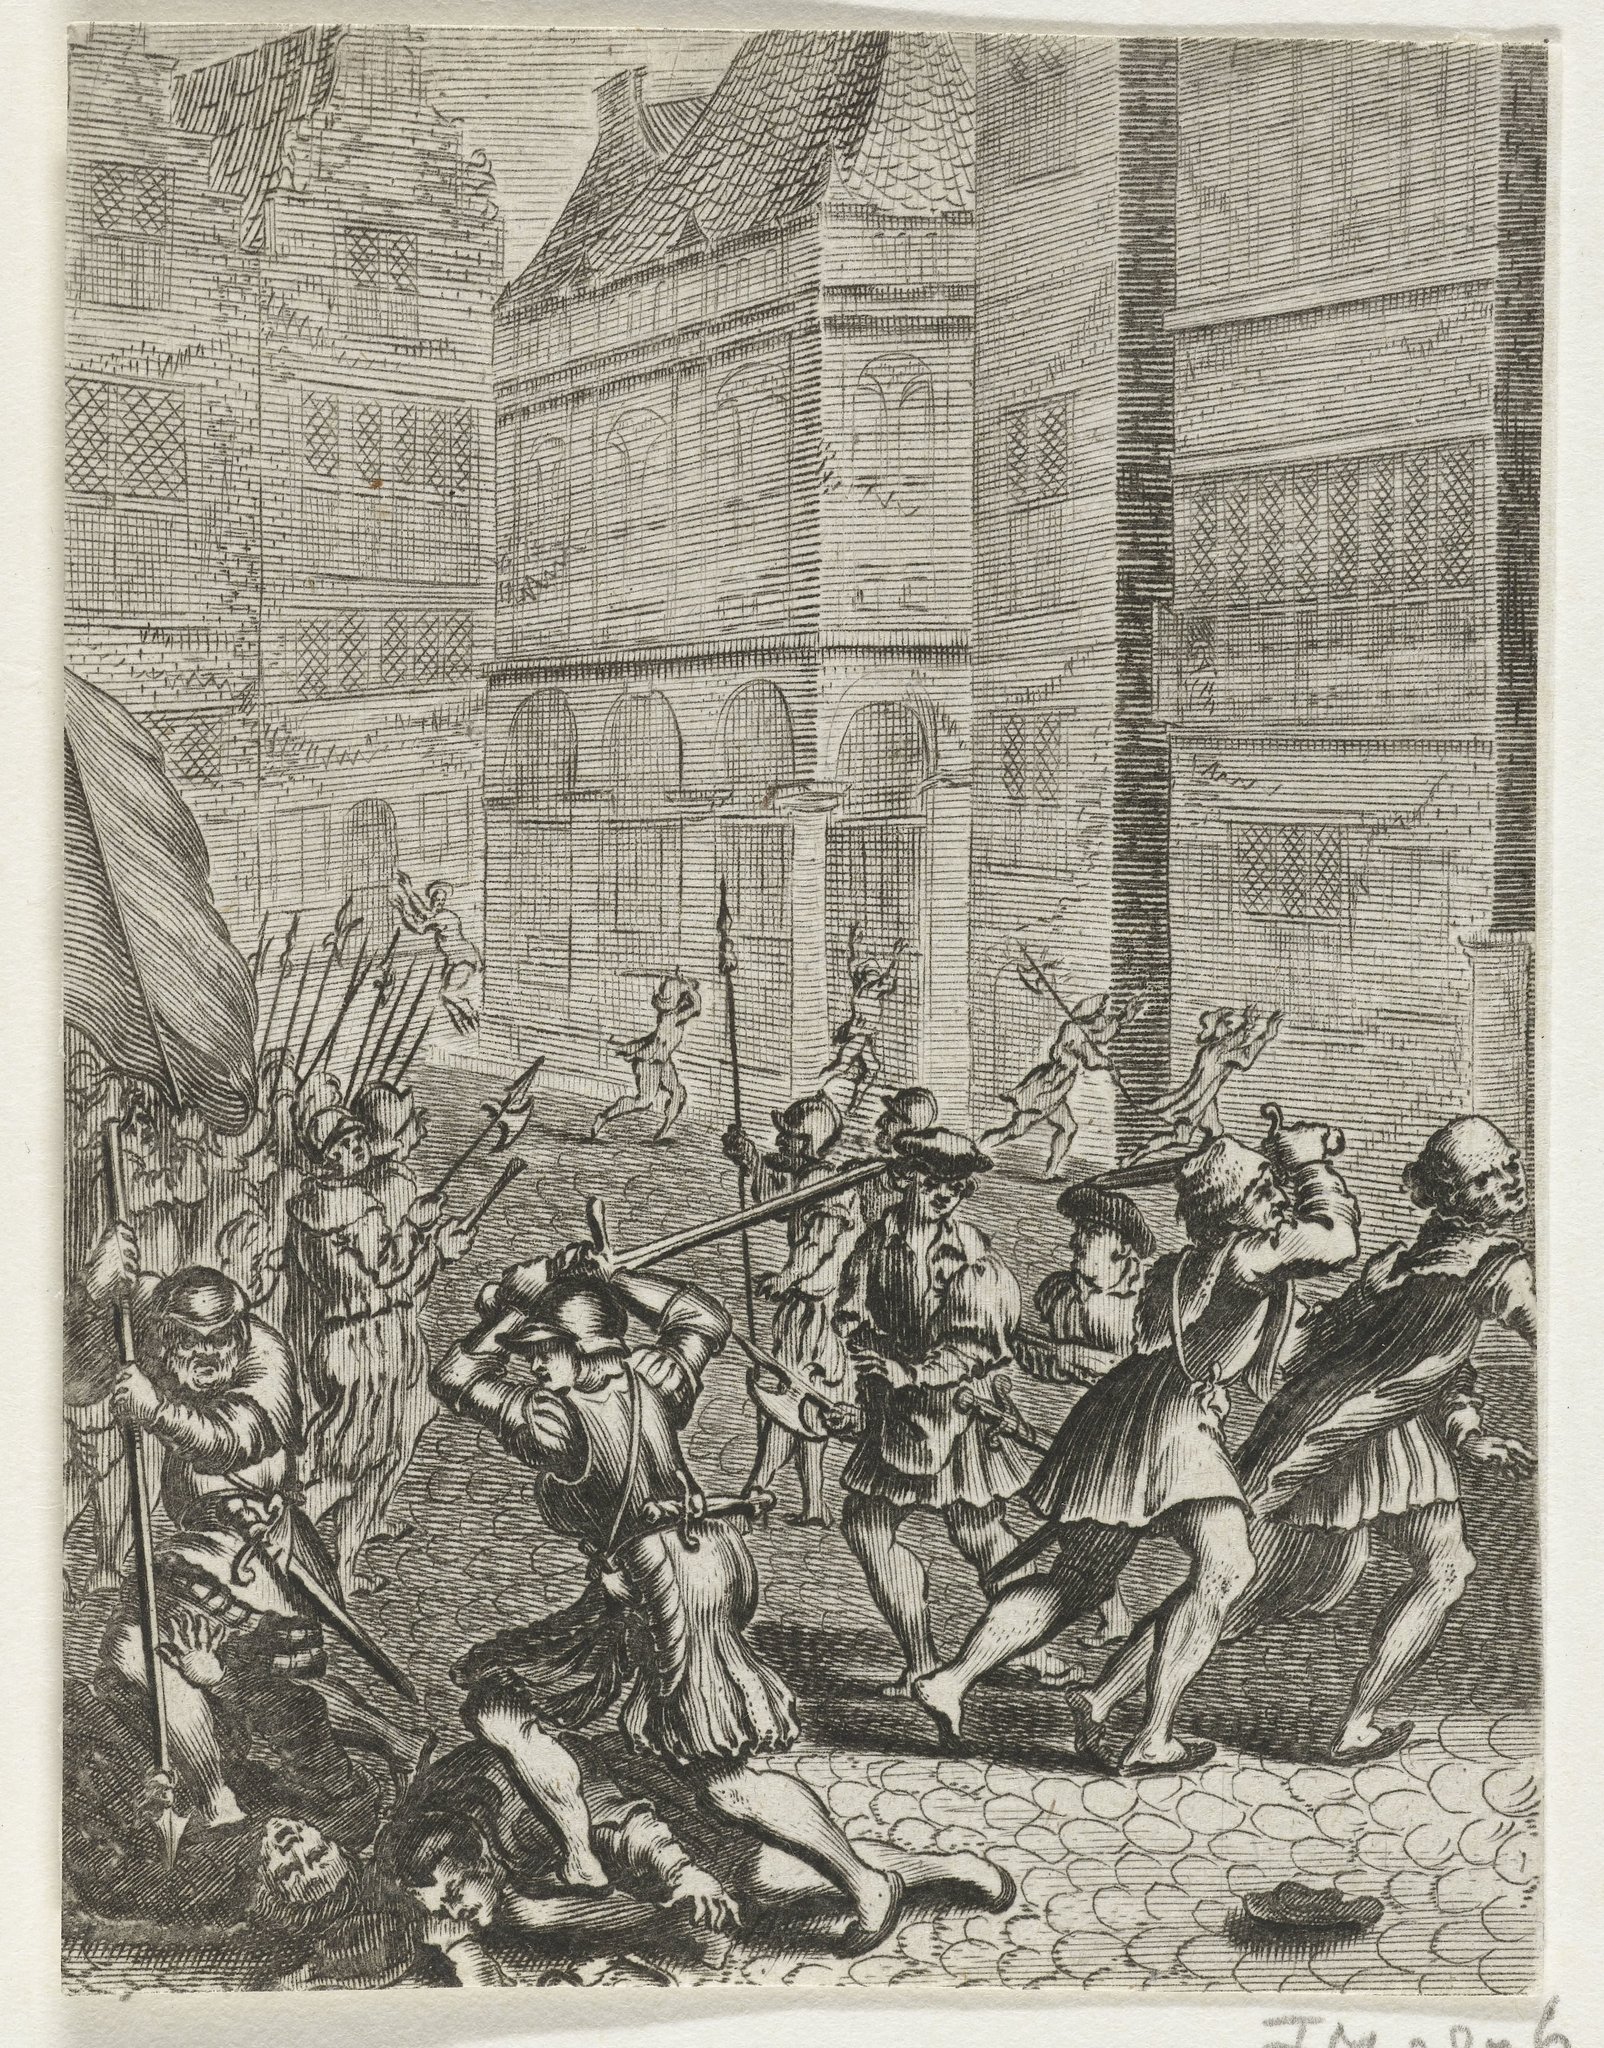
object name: history print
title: De wederdopers bezetten de Dam, 1535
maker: Anonymous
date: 1657-1659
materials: paper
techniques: engraving, etching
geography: northern netherlands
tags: pieter colijn, dam, stadhuis van amsterdam (14e eeuw-1652), wederdopersoproer in amsterdam en friesland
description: Illustratie voor: L. Hortensius, Het boeck D. Lamberti Hortensii (...). Van den oproer der weder-dooperen, J.J. Schipper, Amsterdam 1659. De prenten in deze uitgave zijn gekopieerd naar de anonieme gravures in de eerste uitgave van 1614. Naar het verloren gegane schilderij van Barend Dircksz. in het oude stadhuis te Amsterdam.